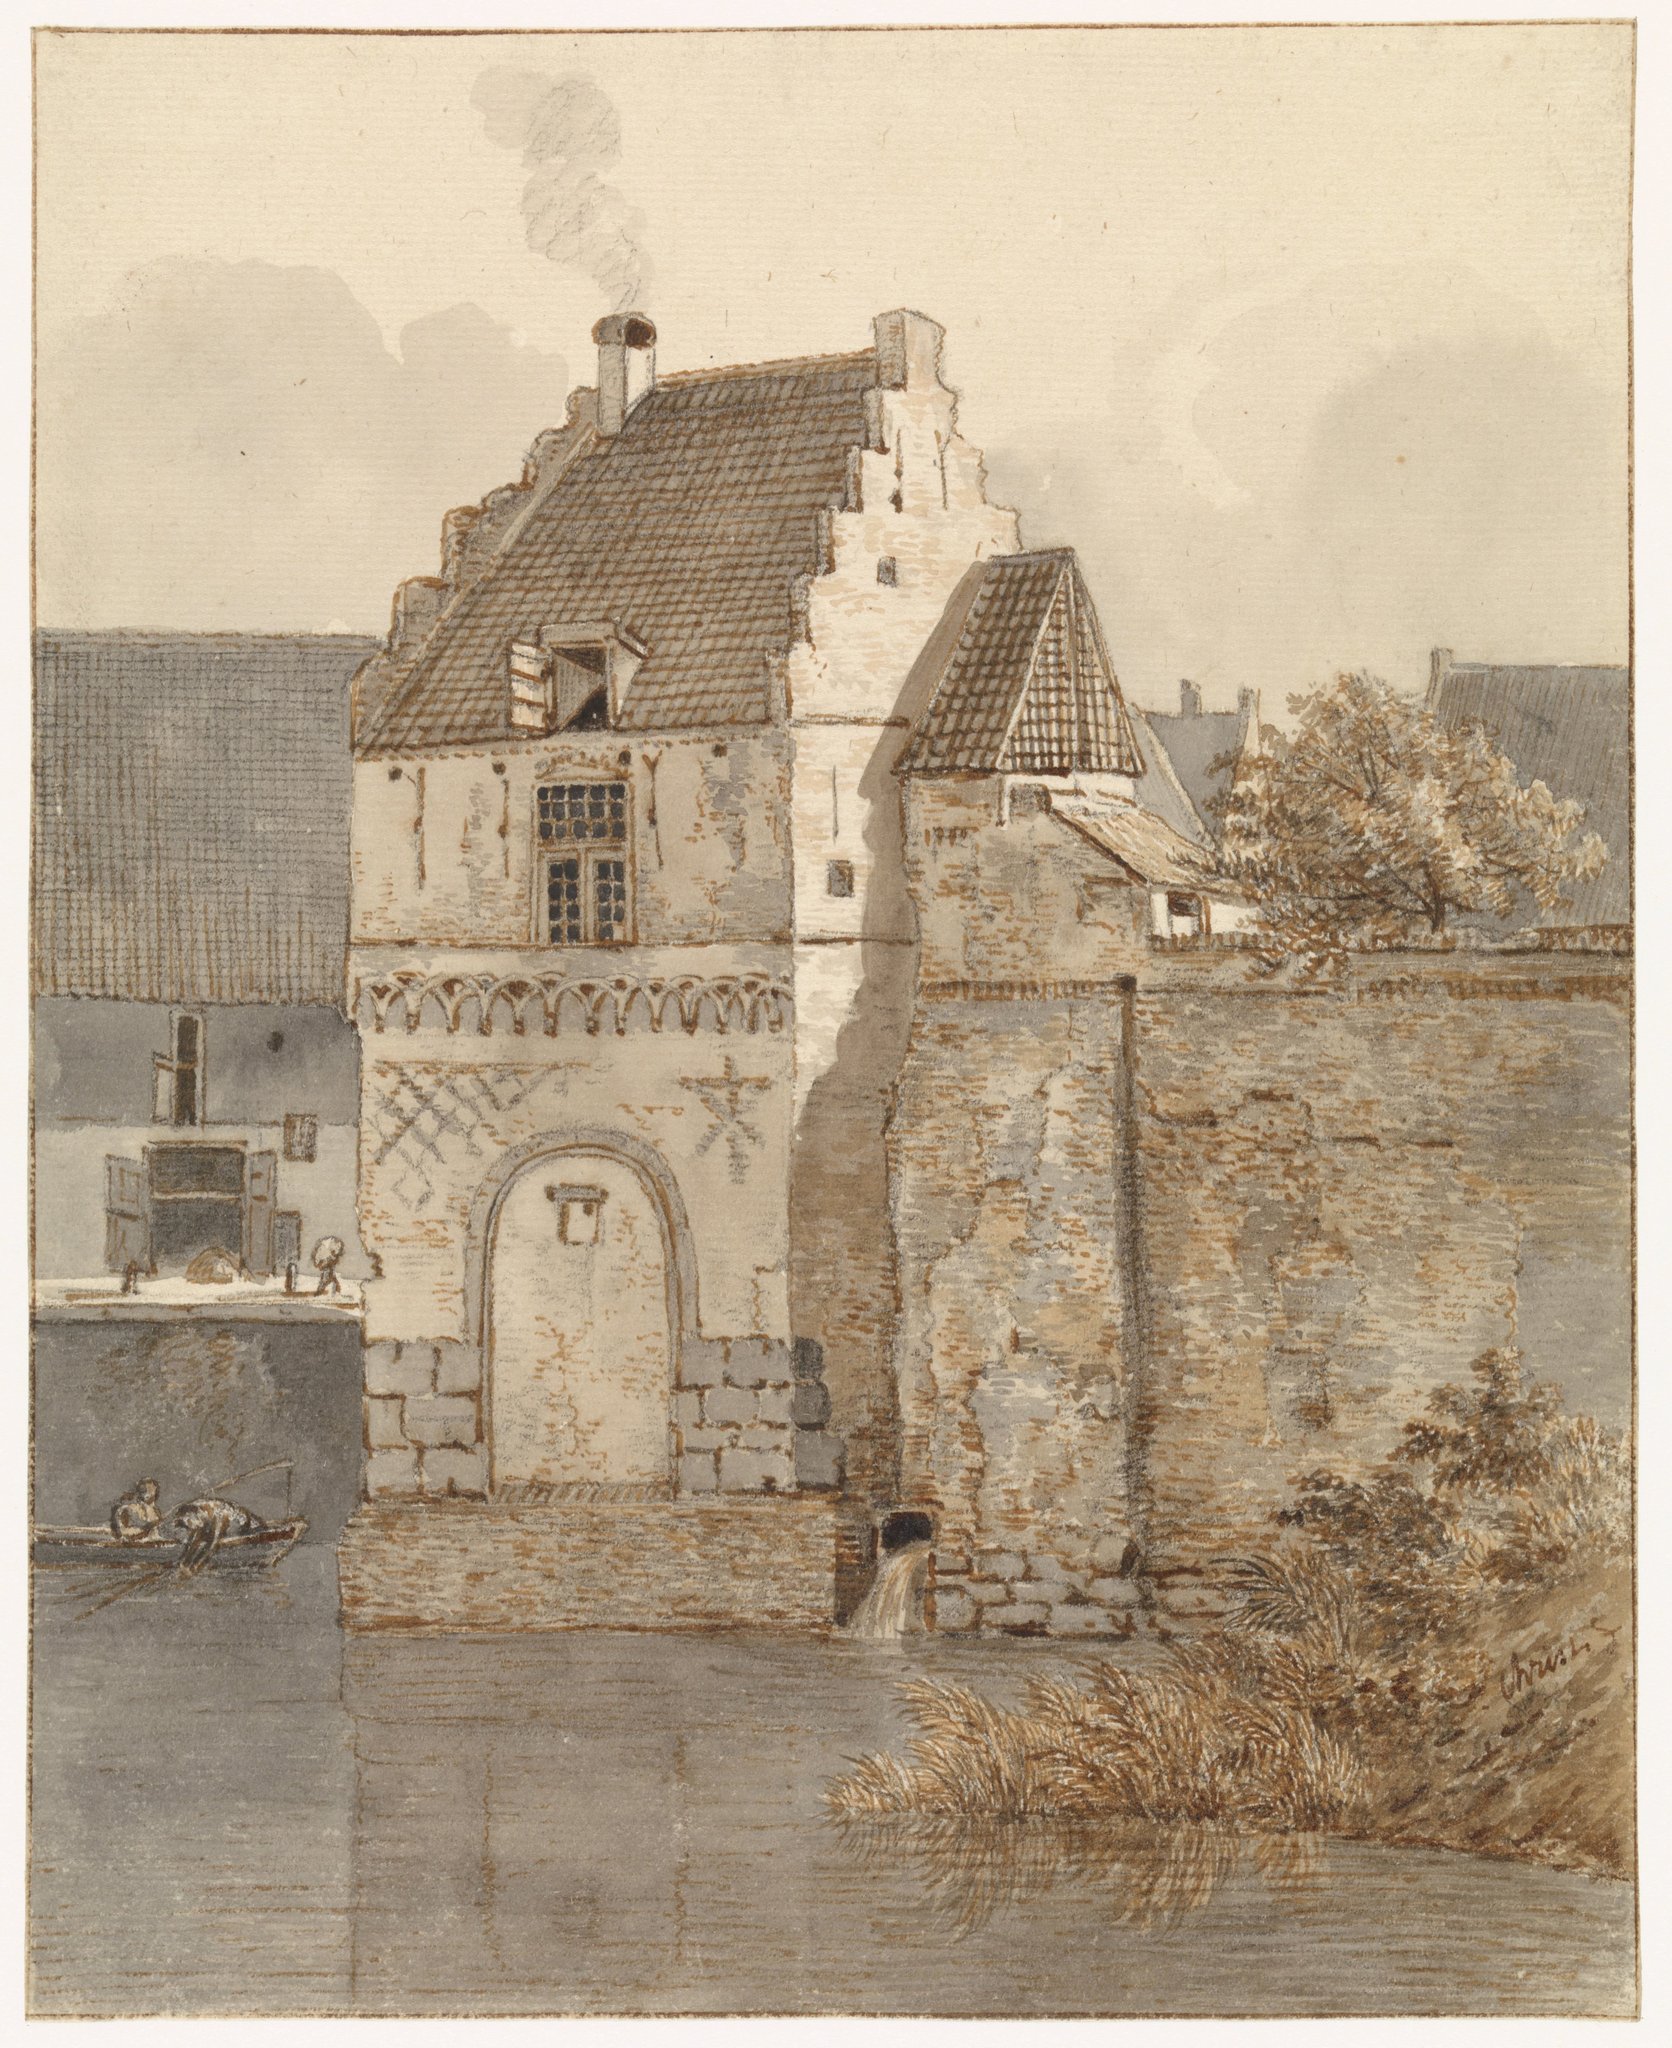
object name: drawing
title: Gezicht op de Bottelpoort aan de Oude Haven te Nijmegen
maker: johannes franciscus christ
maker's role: draughtsman, print maker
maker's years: 1790-1845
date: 1800-1845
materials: chalk, ink, paper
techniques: brush, pen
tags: city-gate, nijmegen